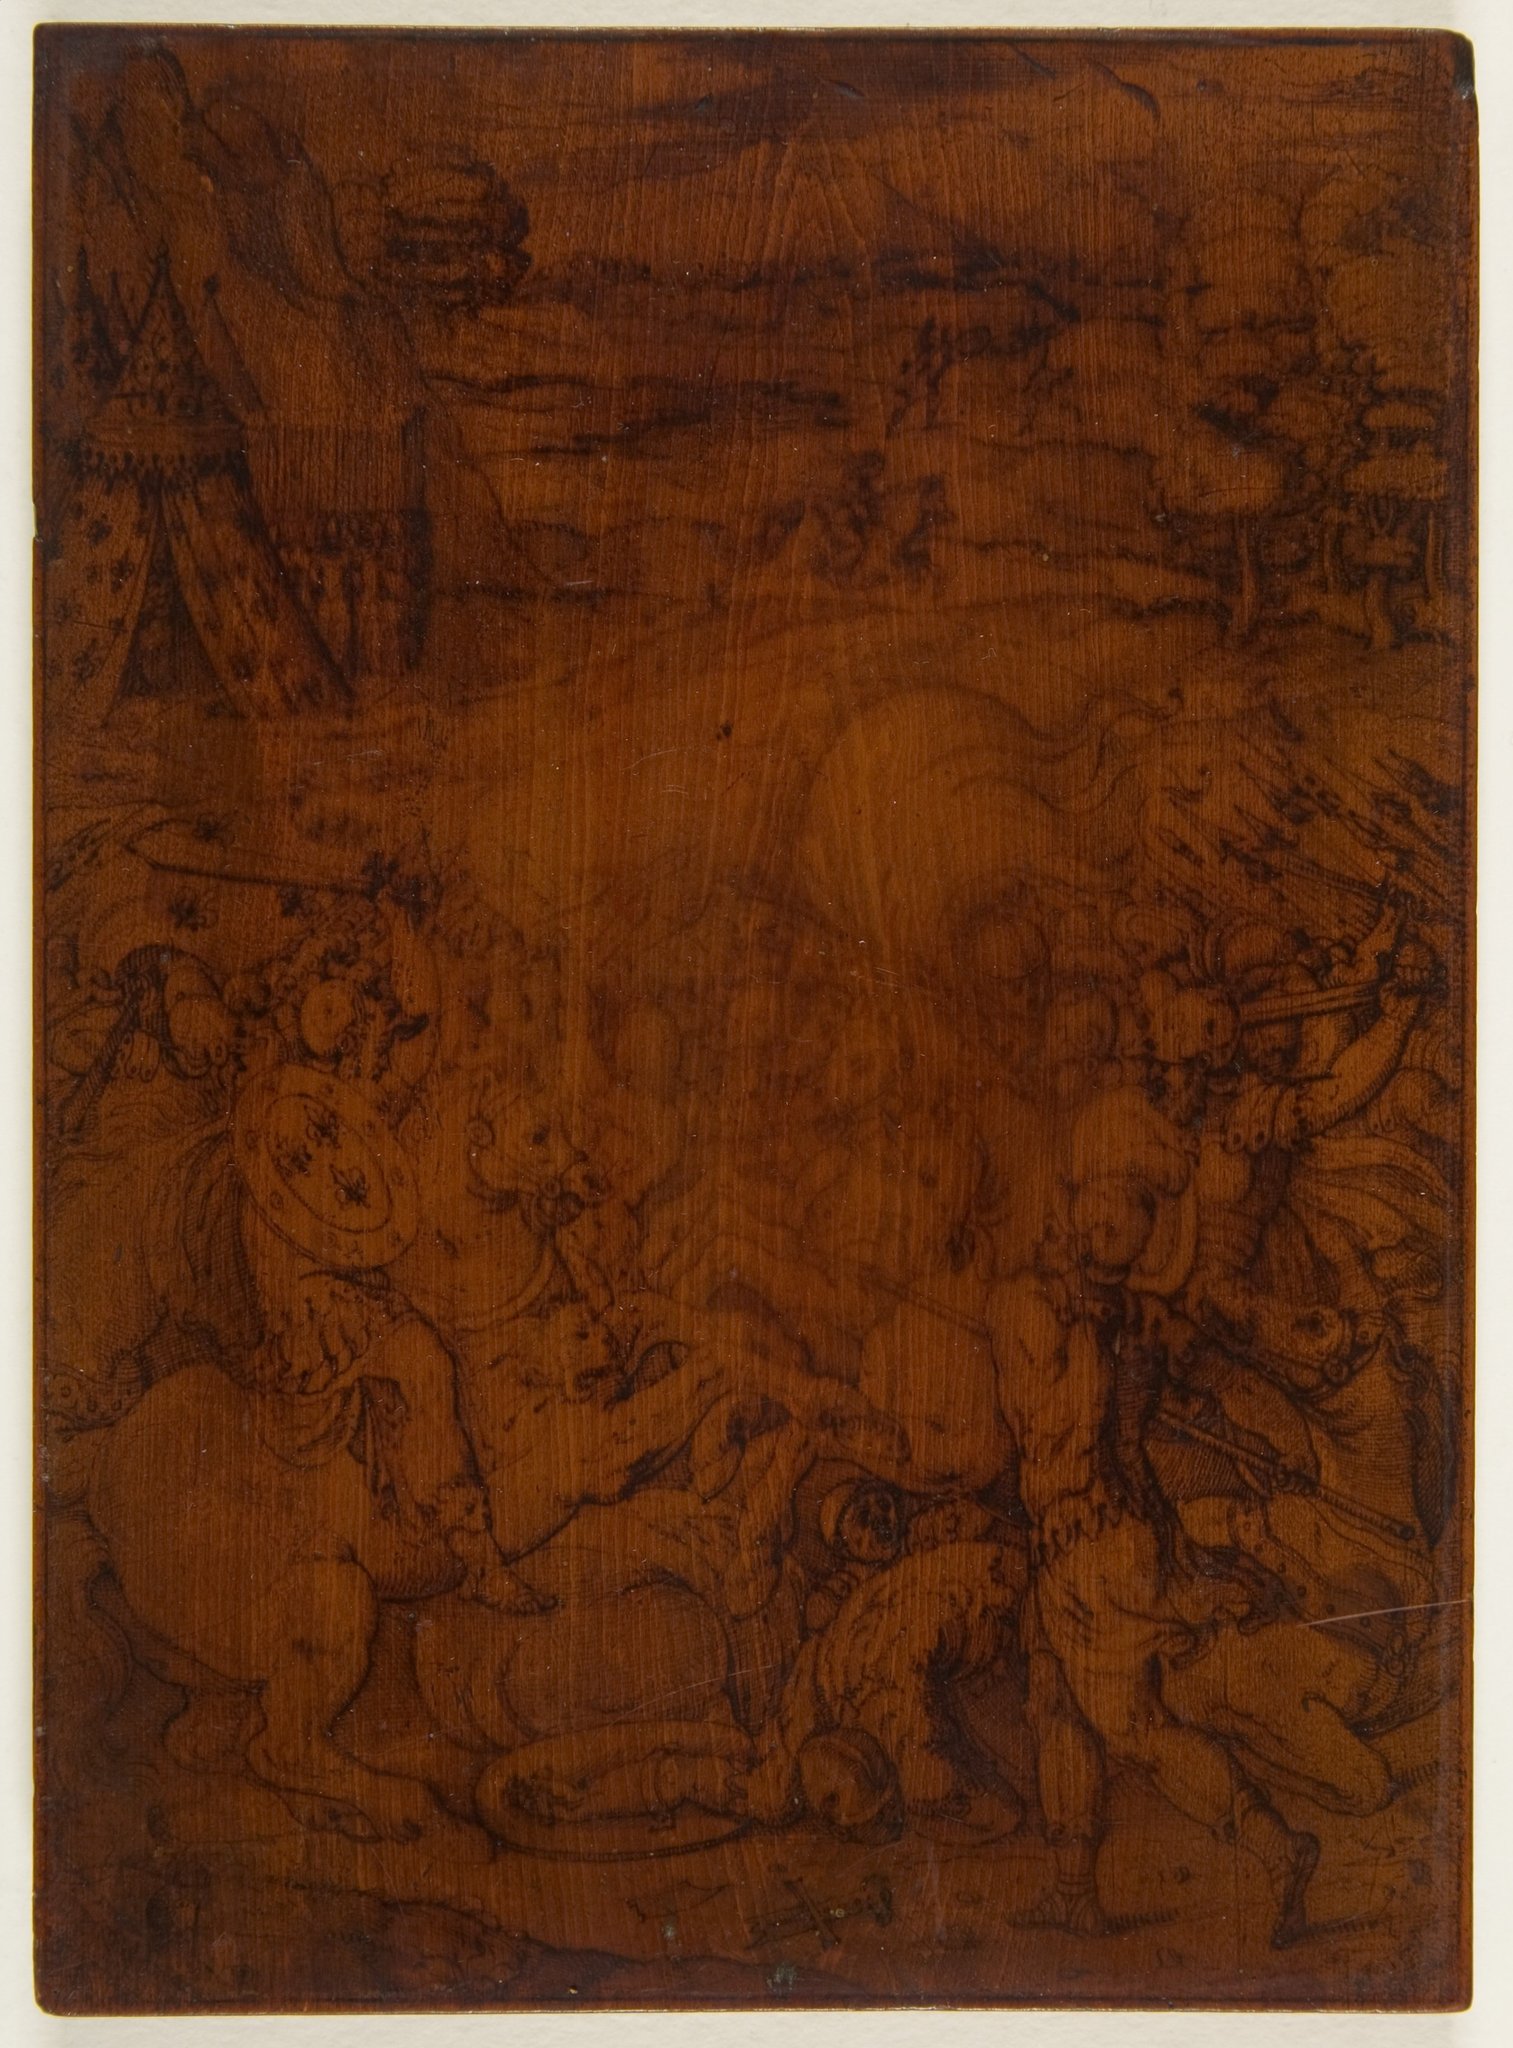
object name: drawing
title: Battle Scene with the Emblems of the Farnese Family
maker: anonymous, italian?, 16th century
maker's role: artist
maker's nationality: italian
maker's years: 1500-1600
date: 1501-1600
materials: ink, panel, wood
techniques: brush, pen, wash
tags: battles,shields,spears,swords,horses